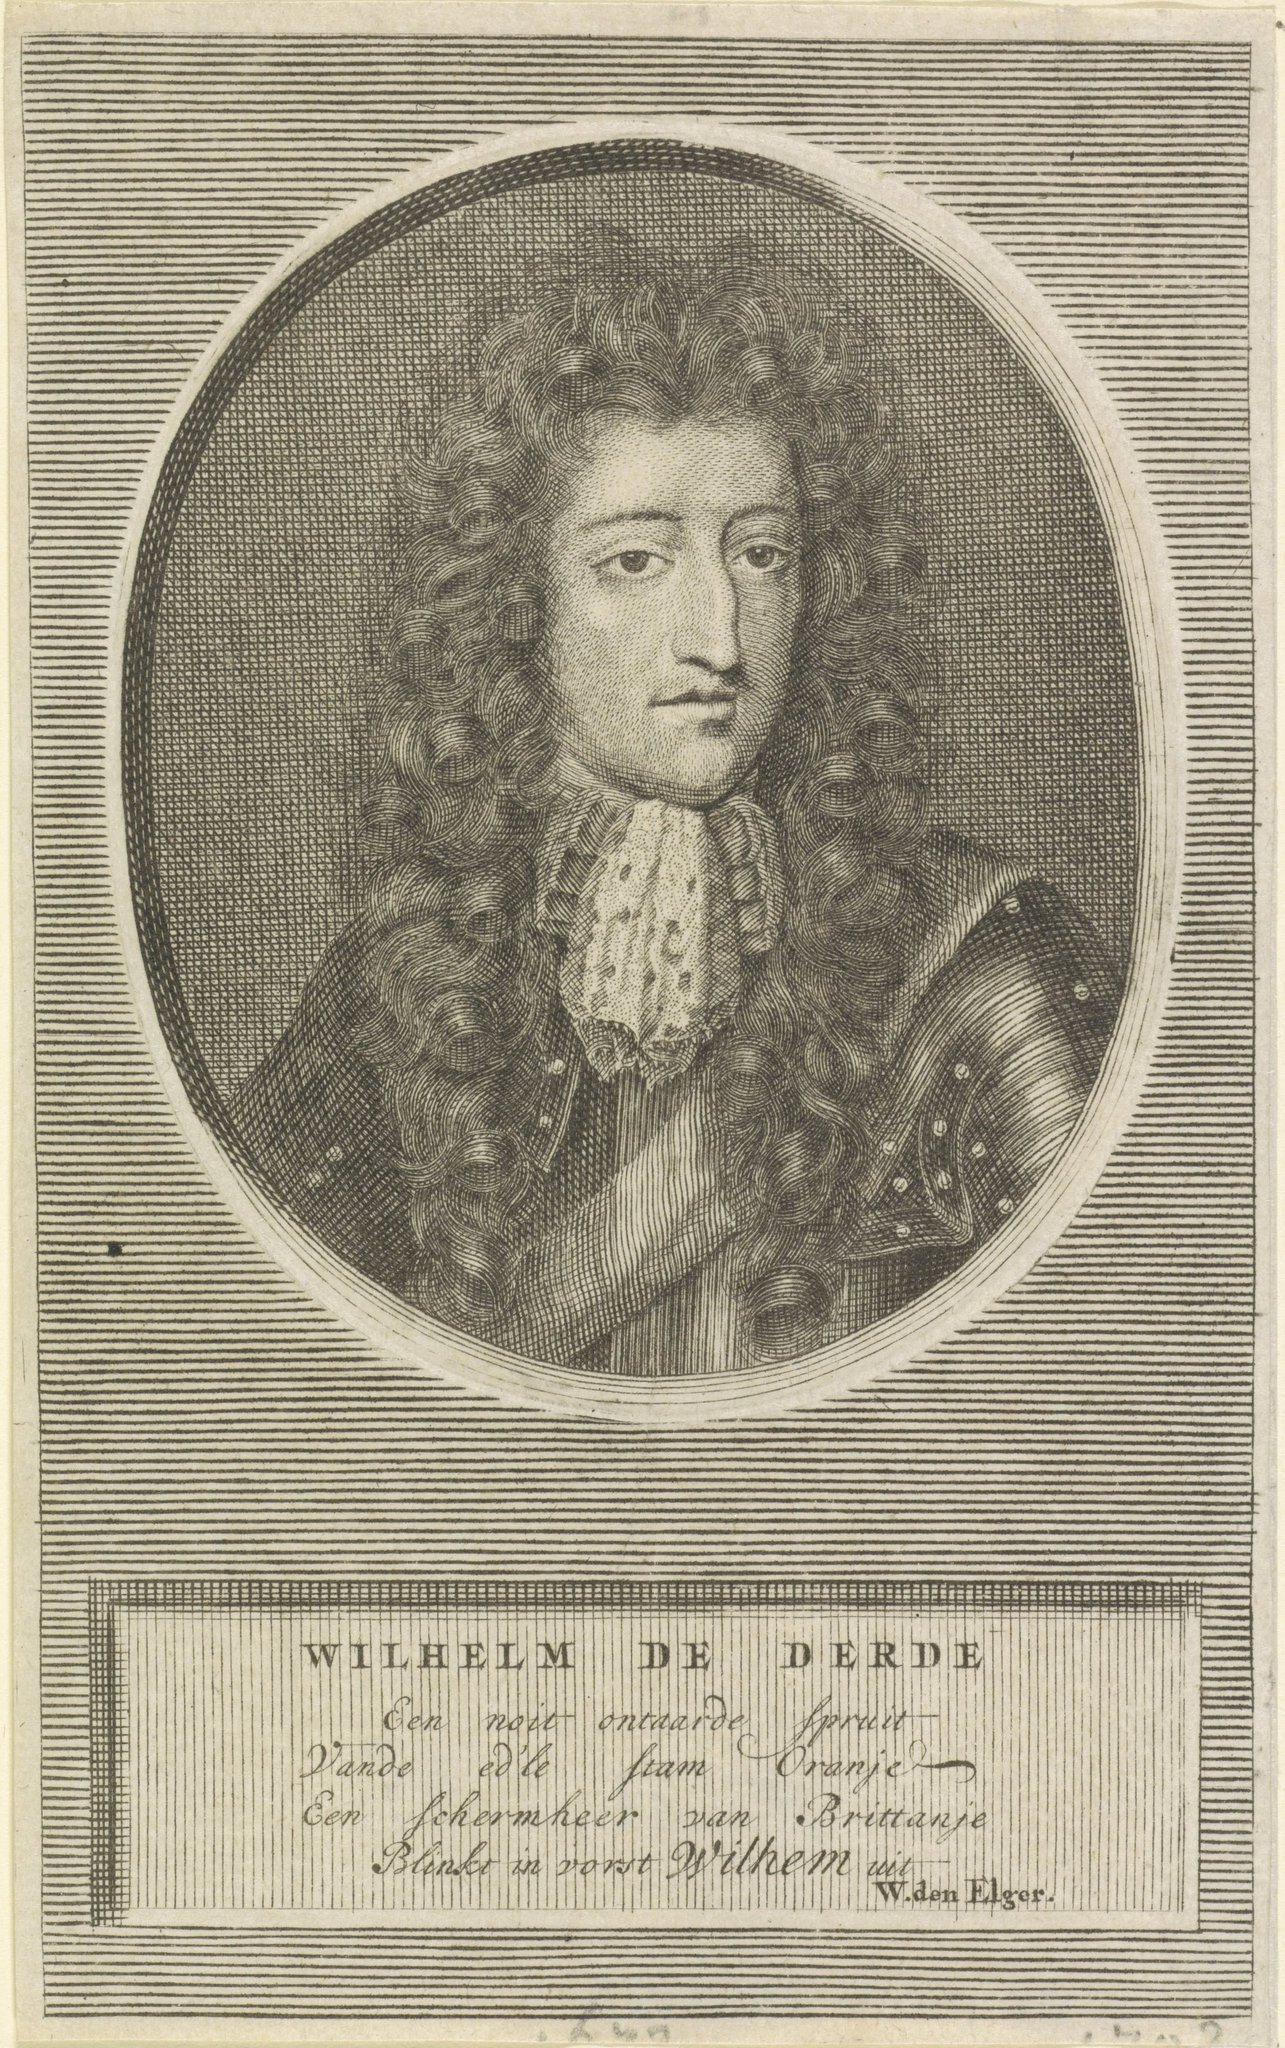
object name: print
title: Portret van Willem III, prins van Oranje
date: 1670-1749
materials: paper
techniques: engraving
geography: low countries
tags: william iii (prince of orange and king of england, scotland, and ireland)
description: De hier vermelde titel verwijst naar de hoogst verkregen titel van de geportretteerde, niet per se naar de titel die de geportretteerde op deze voorstelling draagt.